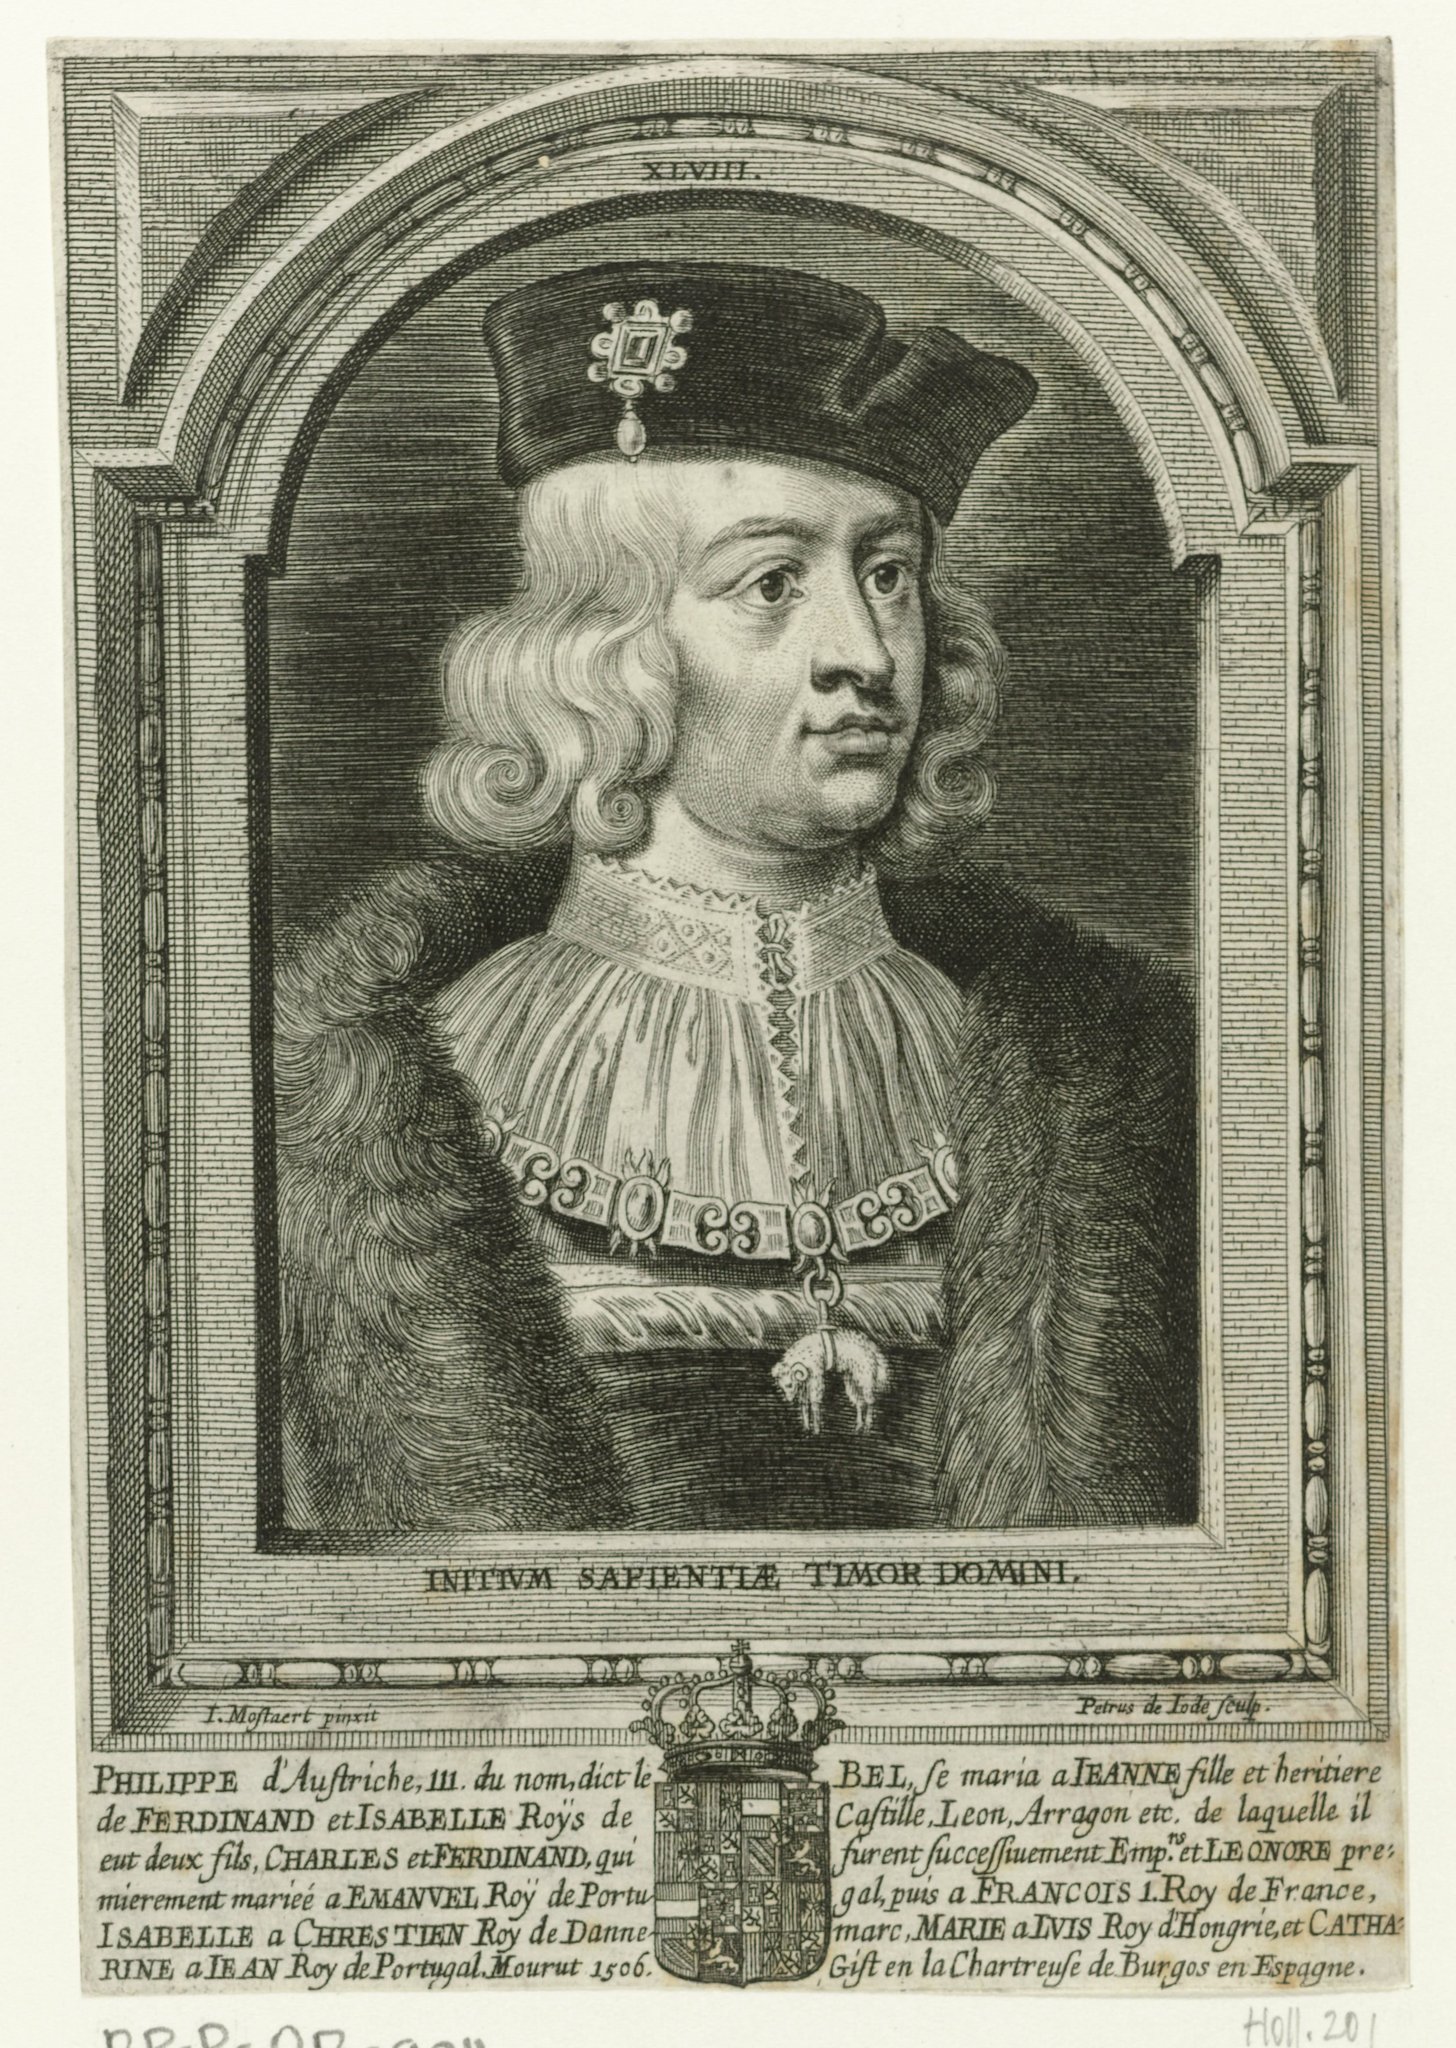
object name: book illustration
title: Portret van Filips III de Schone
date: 1661-1663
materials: paper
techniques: engraving, etching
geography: antwerp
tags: bruges, filips de schone (hertog van bourgondië), knighthood order of the golden fleece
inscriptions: collector's mark: Lugt 240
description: Busteportret van Filips III de Schone, met baret. Hij draagt een mantel en een keten met de Orde van het Gulden Vlies. Het portret is gevat in een boogvormige omlijsting met vierkant randwerk en een motto in het Latijn. In de marge het wapenschild van de geportretteerde en een zesregelig onderschrift in het Frans. Prent uit een boek waarin 54 prenten met portretten.